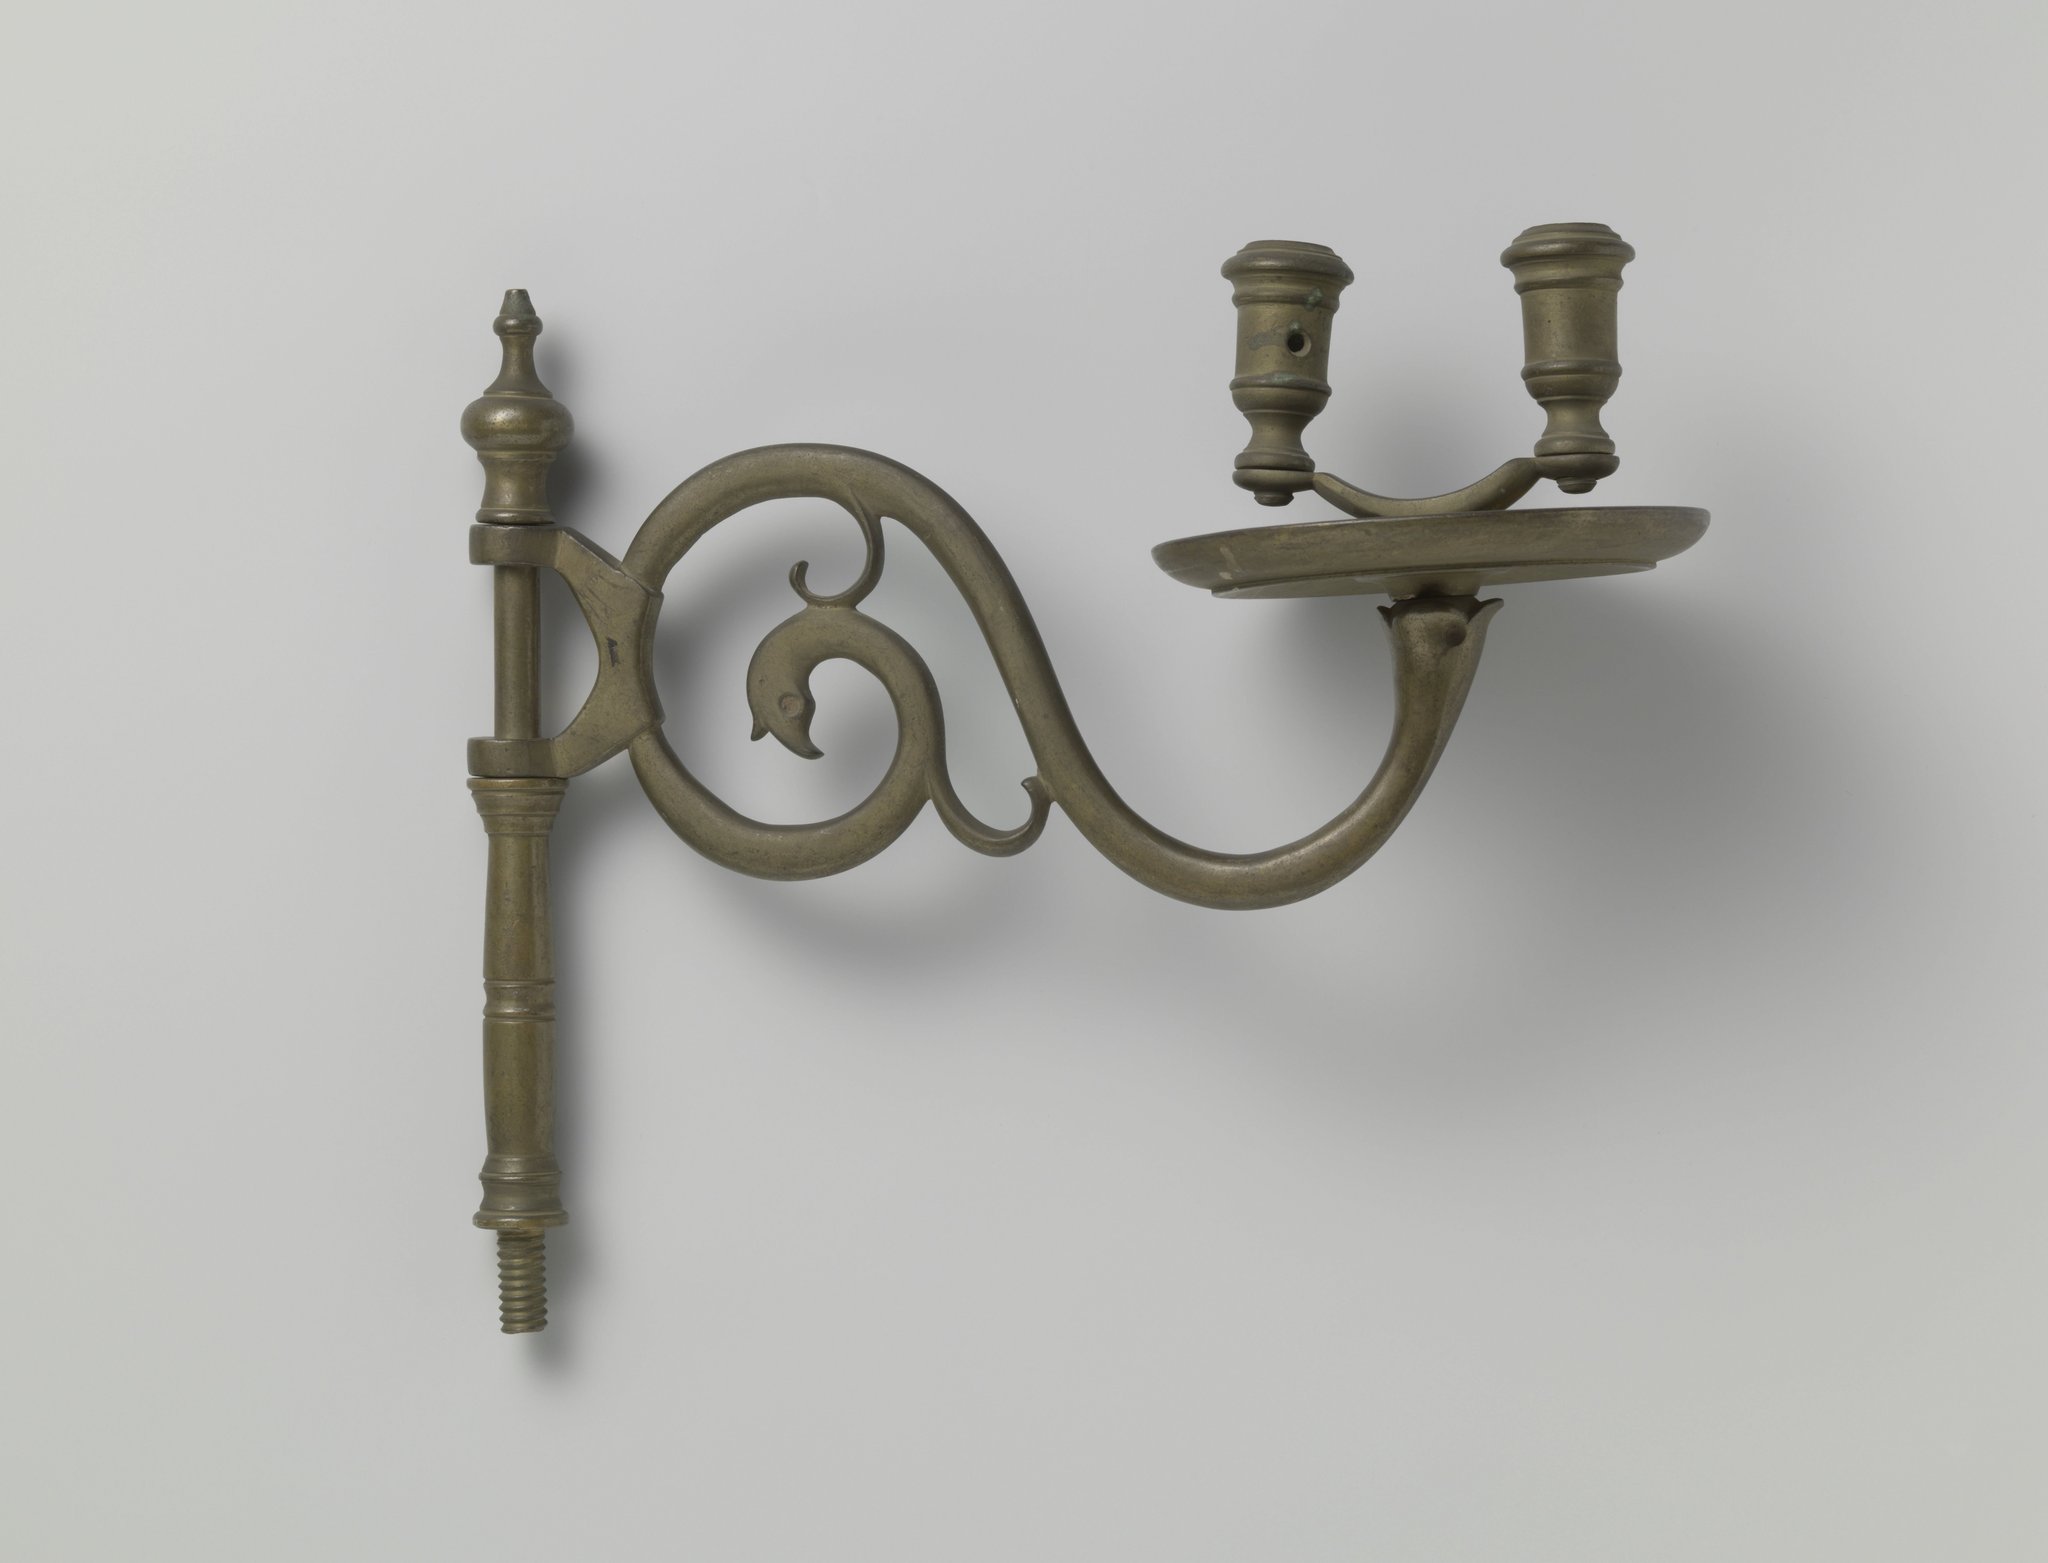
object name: kaarsenhouder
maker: Anonymous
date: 1700-1725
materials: brass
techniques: casting, screwed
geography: netherlands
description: Het voorwerp is samengesteld uit de volgende onderdelen: de baluster, de arm, de vetvanger, de draaier, twee kaarsenhouders en de knop. De aan beide einden van een schroefdraad voorziene baluster is geprofileerd en heeft boven een glad stuk, waarop de arm is gestoken, die met een knop is vastgezet. De arm is tweemaal gebogen, aan één kant eindigend in een vogel- of dolfijnenkop, op het andere eind in een verdikking. Hierin is de draaier op de aan de onderkant grof geprofileerde ronde vetvanger geschroefd. Op de draaier zijn de twee korte geprofileerde kaarsenhouders geschroefd. De draaier is gescheurd.